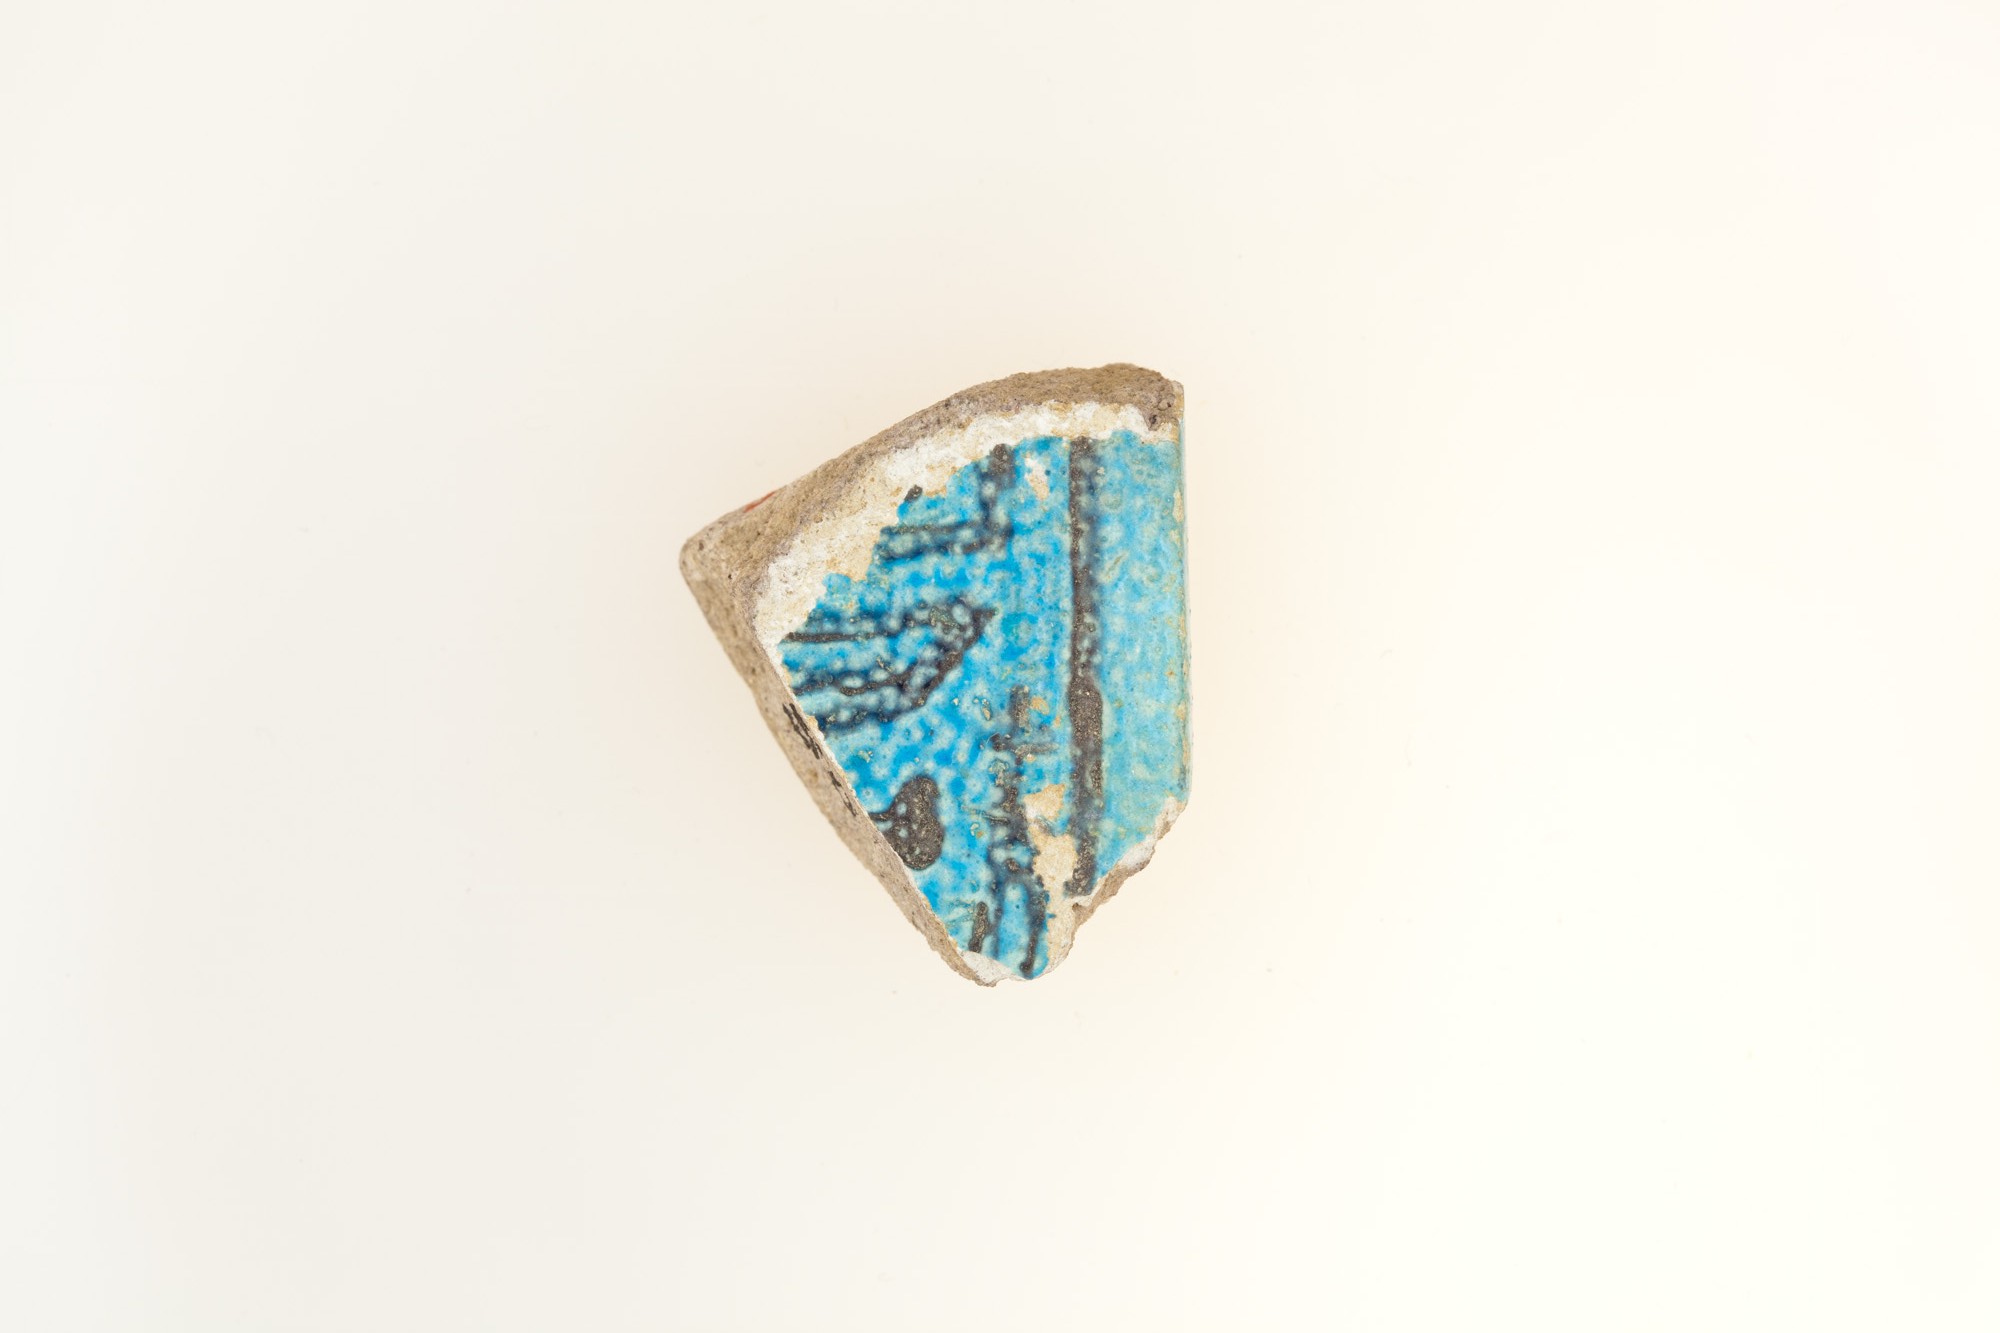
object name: menat fragment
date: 1479-1458 BCE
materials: faience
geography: egypt